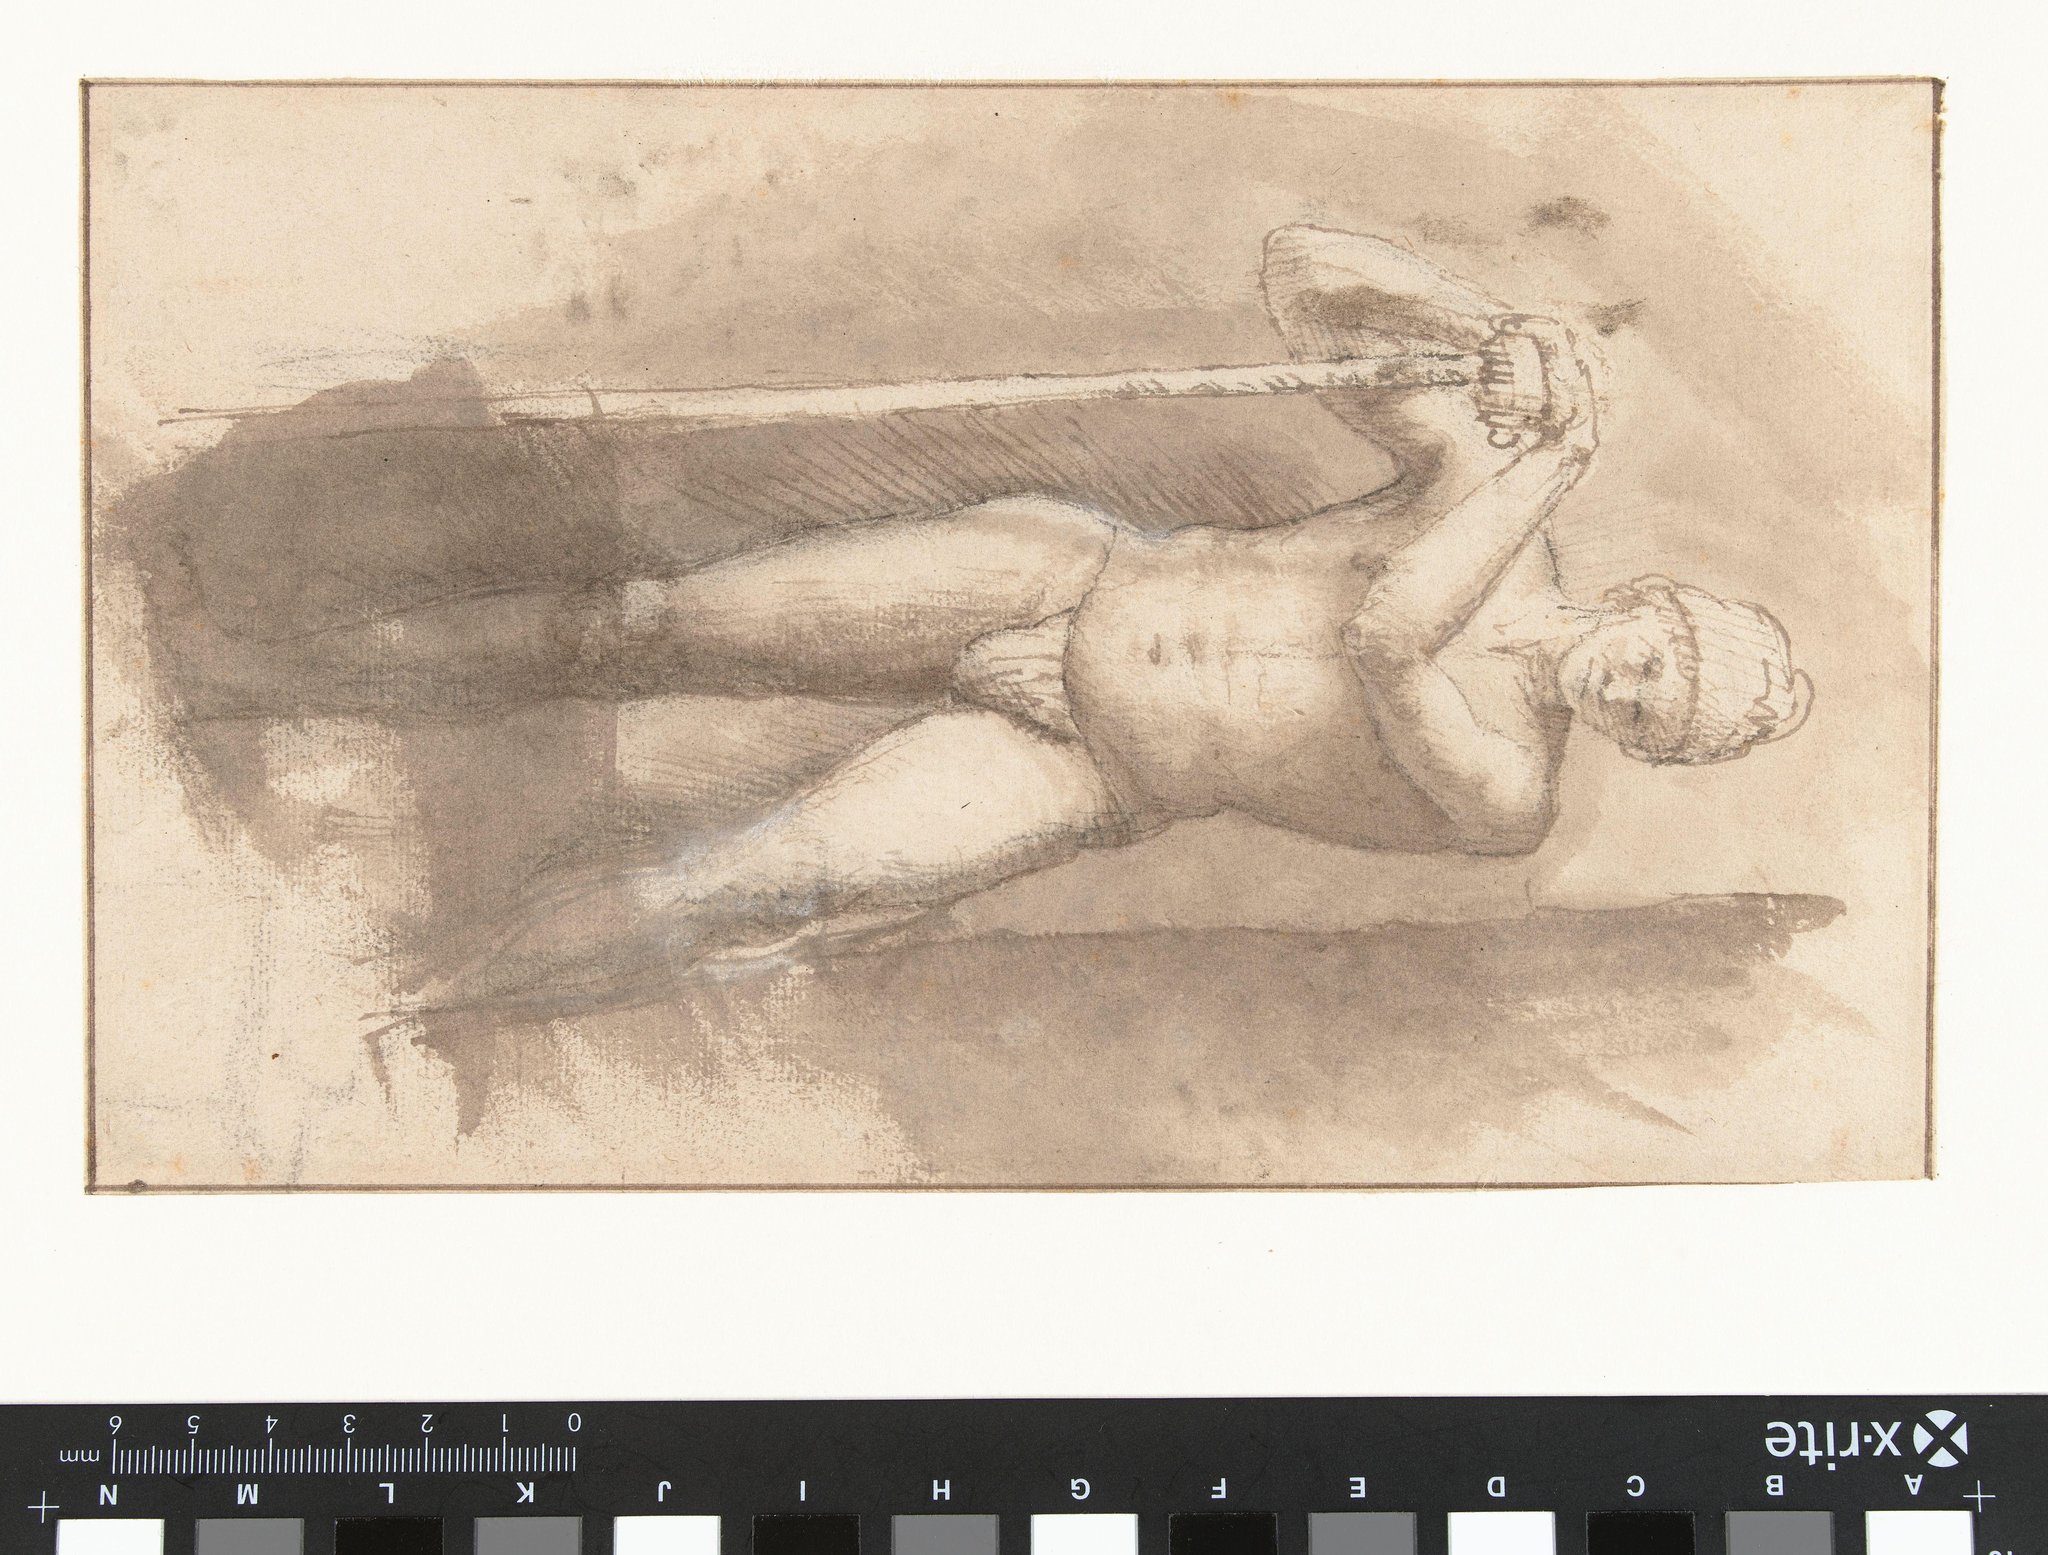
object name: drawing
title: Staand mannelijk naakt met stok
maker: constantijn à renesse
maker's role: draughtsman, print maker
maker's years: 1626-1680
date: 1650-1655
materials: chalk, paint, ink, paper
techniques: brush, pen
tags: standing figure